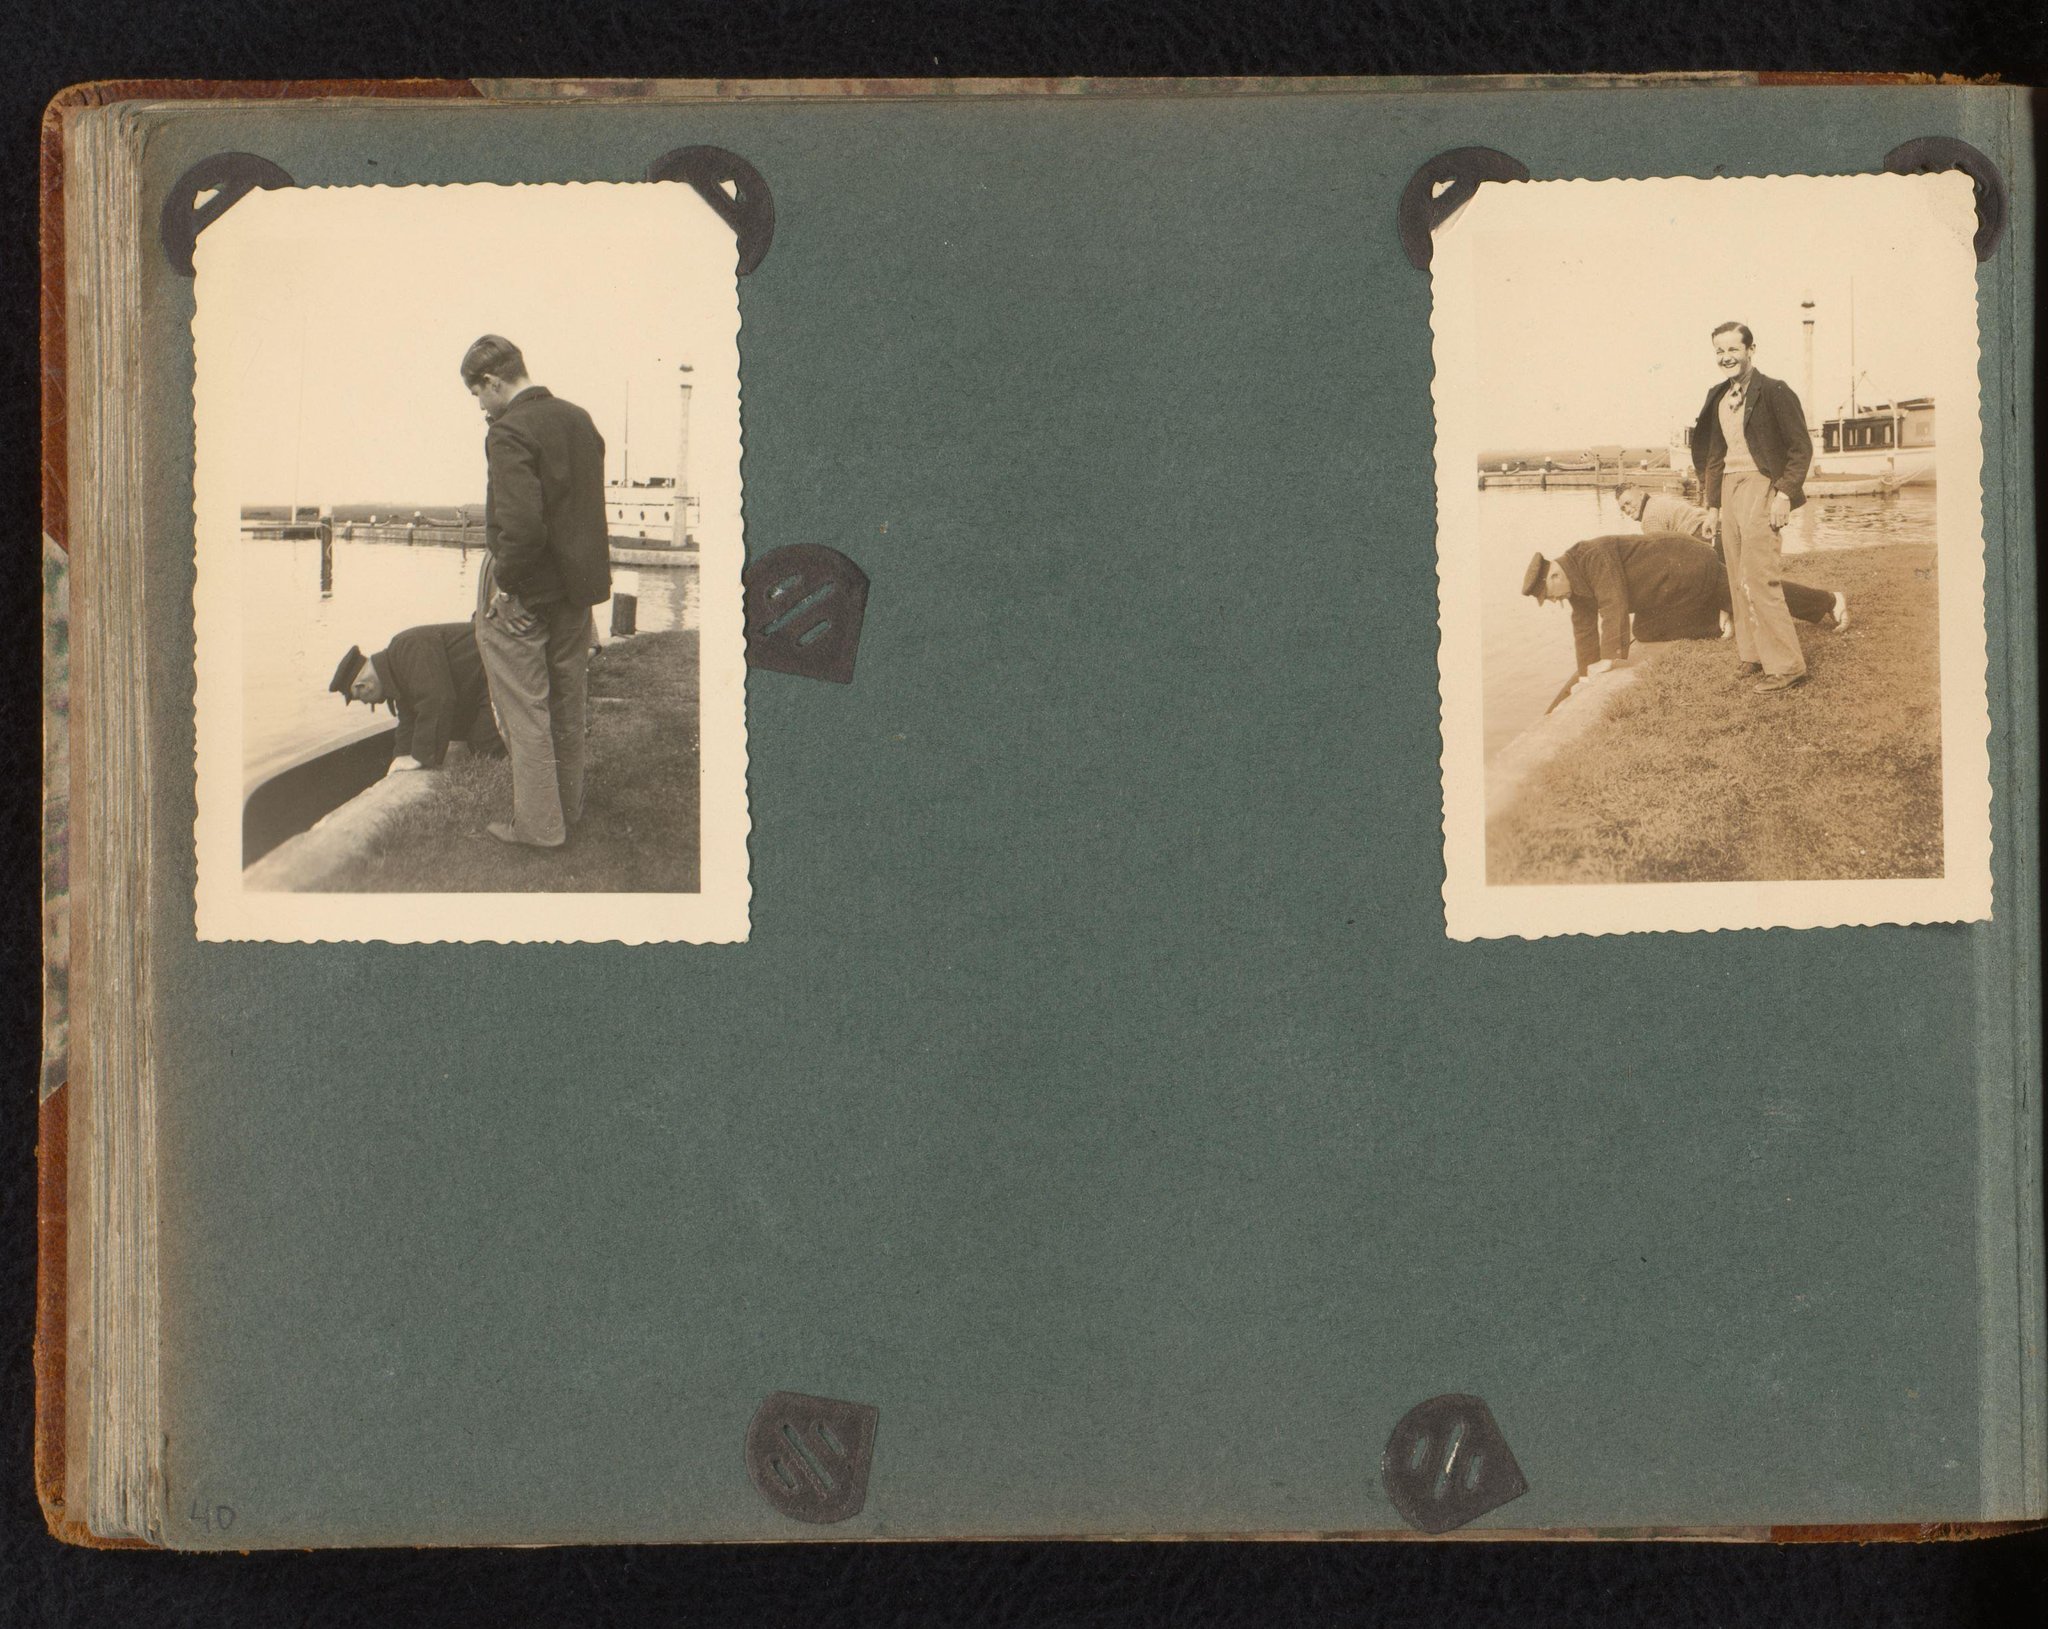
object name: album leaf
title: Twee foto's van drie mannen die een boot aan de kade halen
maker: Anonymous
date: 1920-1930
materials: paper, cardboard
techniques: gelatin silver print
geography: netherlands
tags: adult man, quay, boat propelled by man or animal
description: Deze foto's maken deel uit van een album.